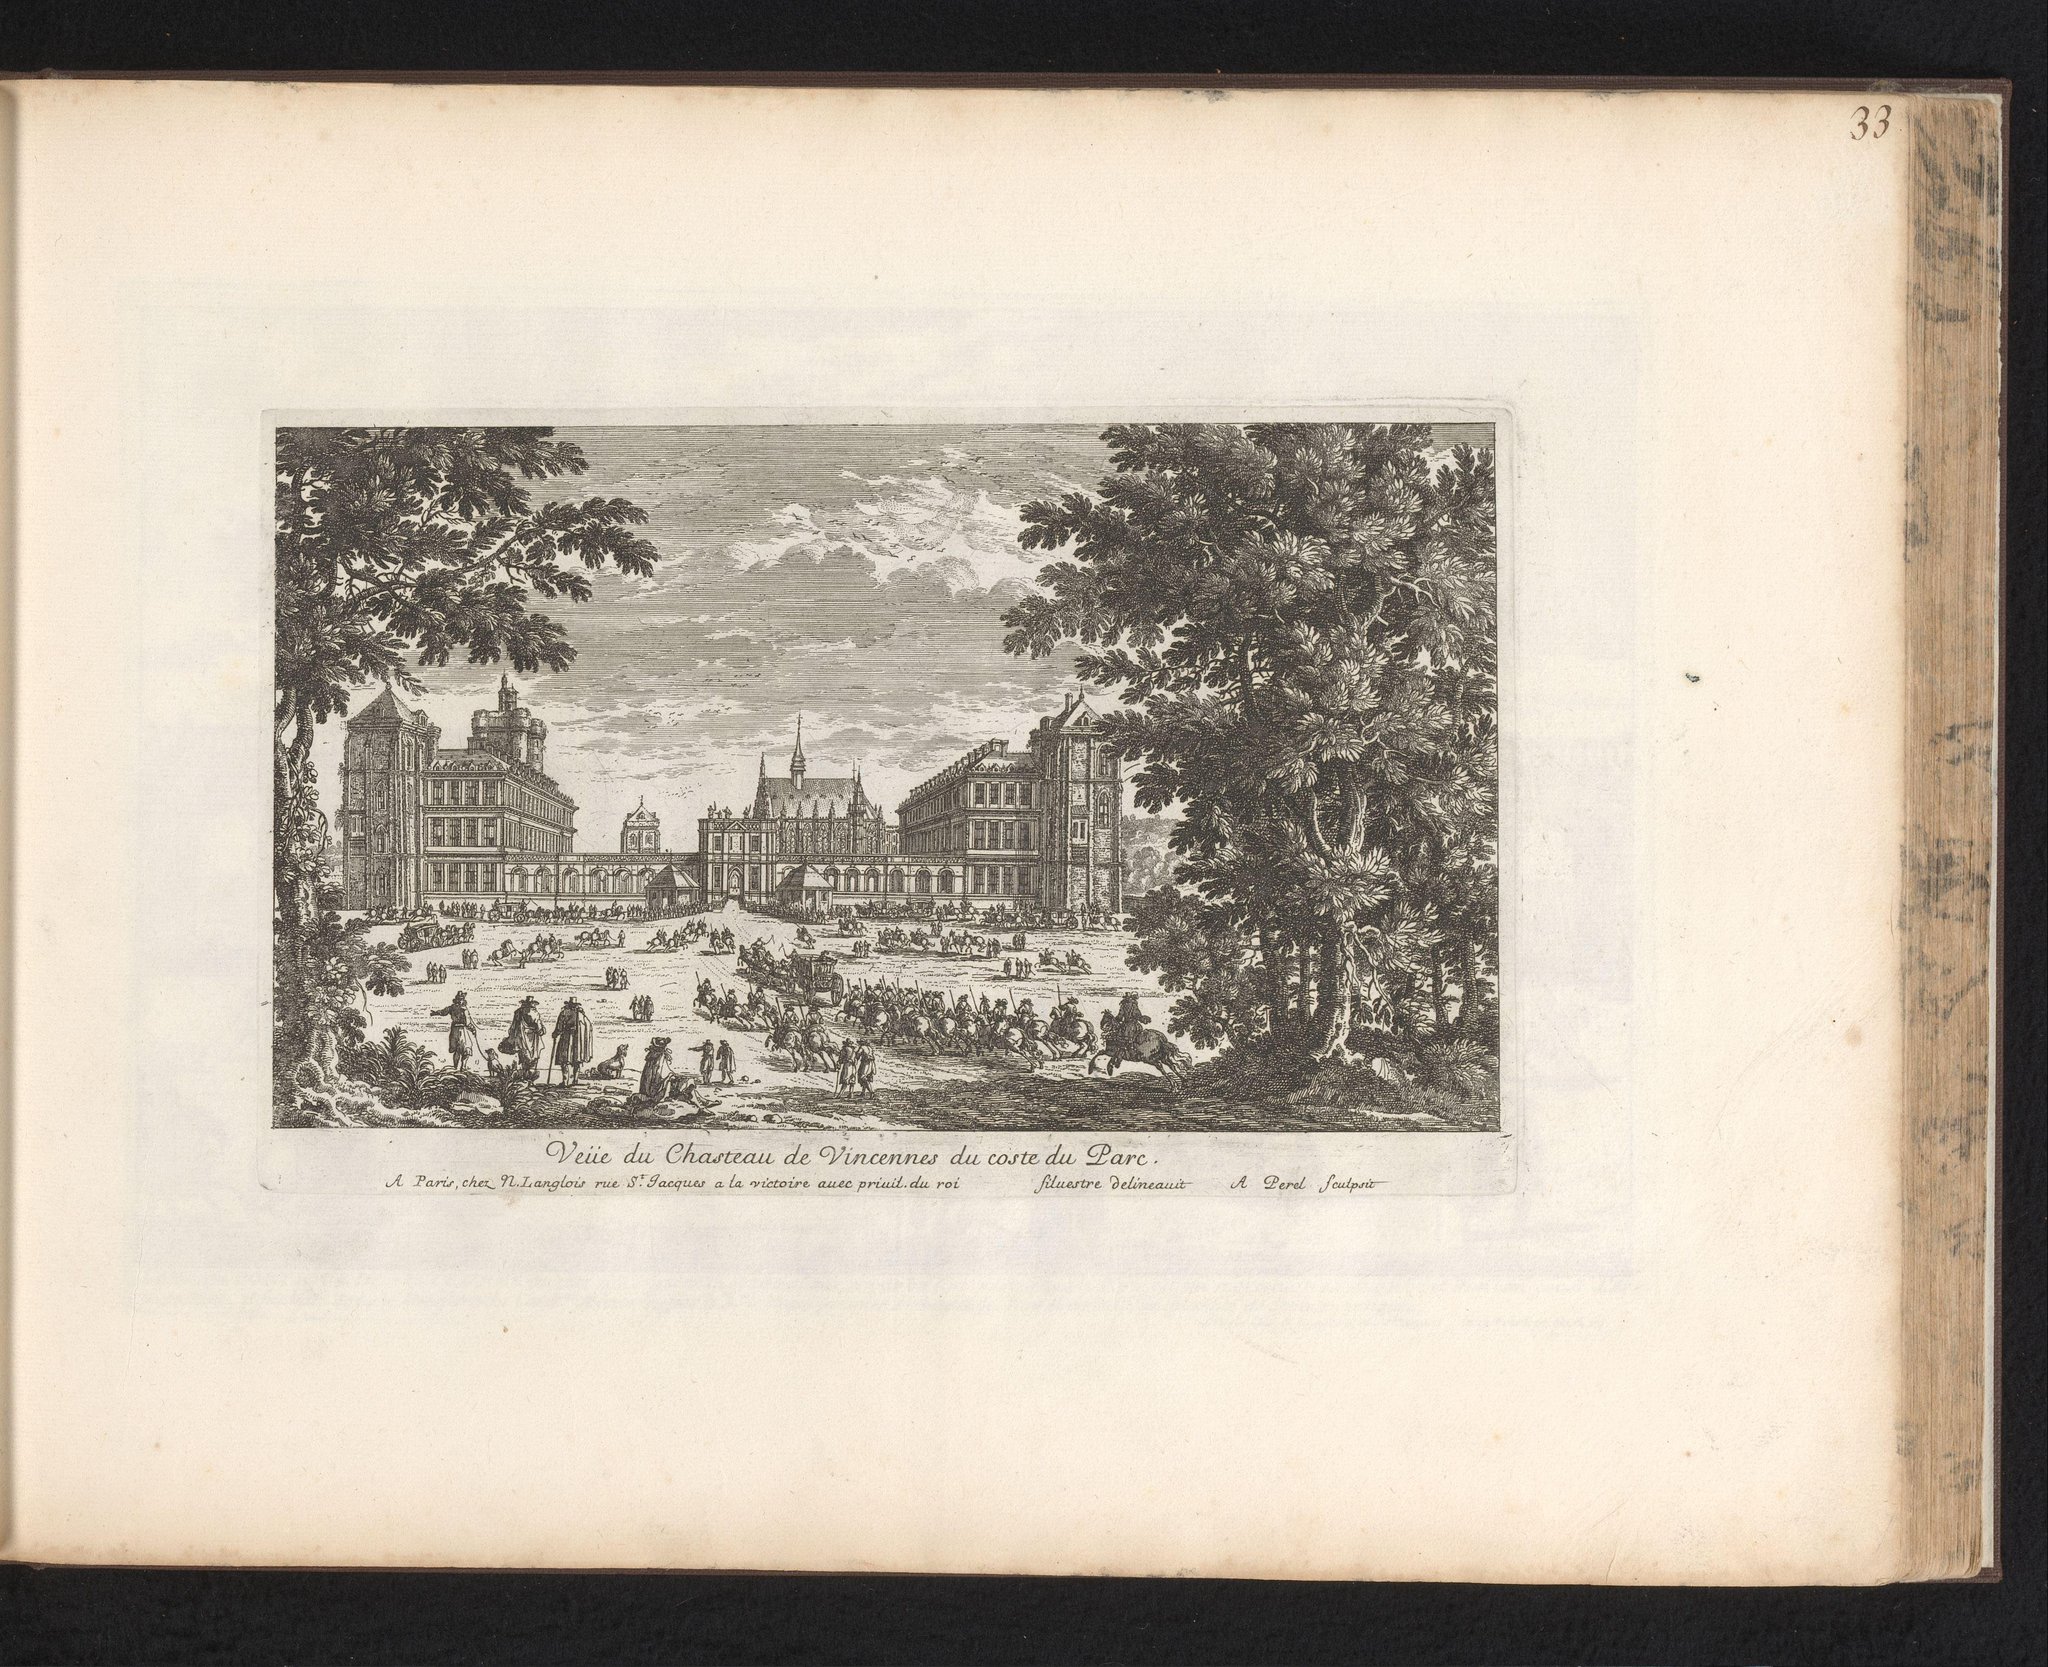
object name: print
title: Stadsgezichten en landschappen in Frankrijk en Italië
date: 1648-1695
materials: paper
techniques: etching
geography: paris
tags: castle, landscape with tower or castle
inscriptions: collector's mark: Lugt 2228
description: Prenten met het signatuur 'Perelle' kunnen zowel door vader Gabriel als door zonen Nicolas en Adam gemaakt zijn. De uitgevers vader en zoon Nicolas Langlois worden allebei vermeld als N. Langlois op hetzelfde adres.